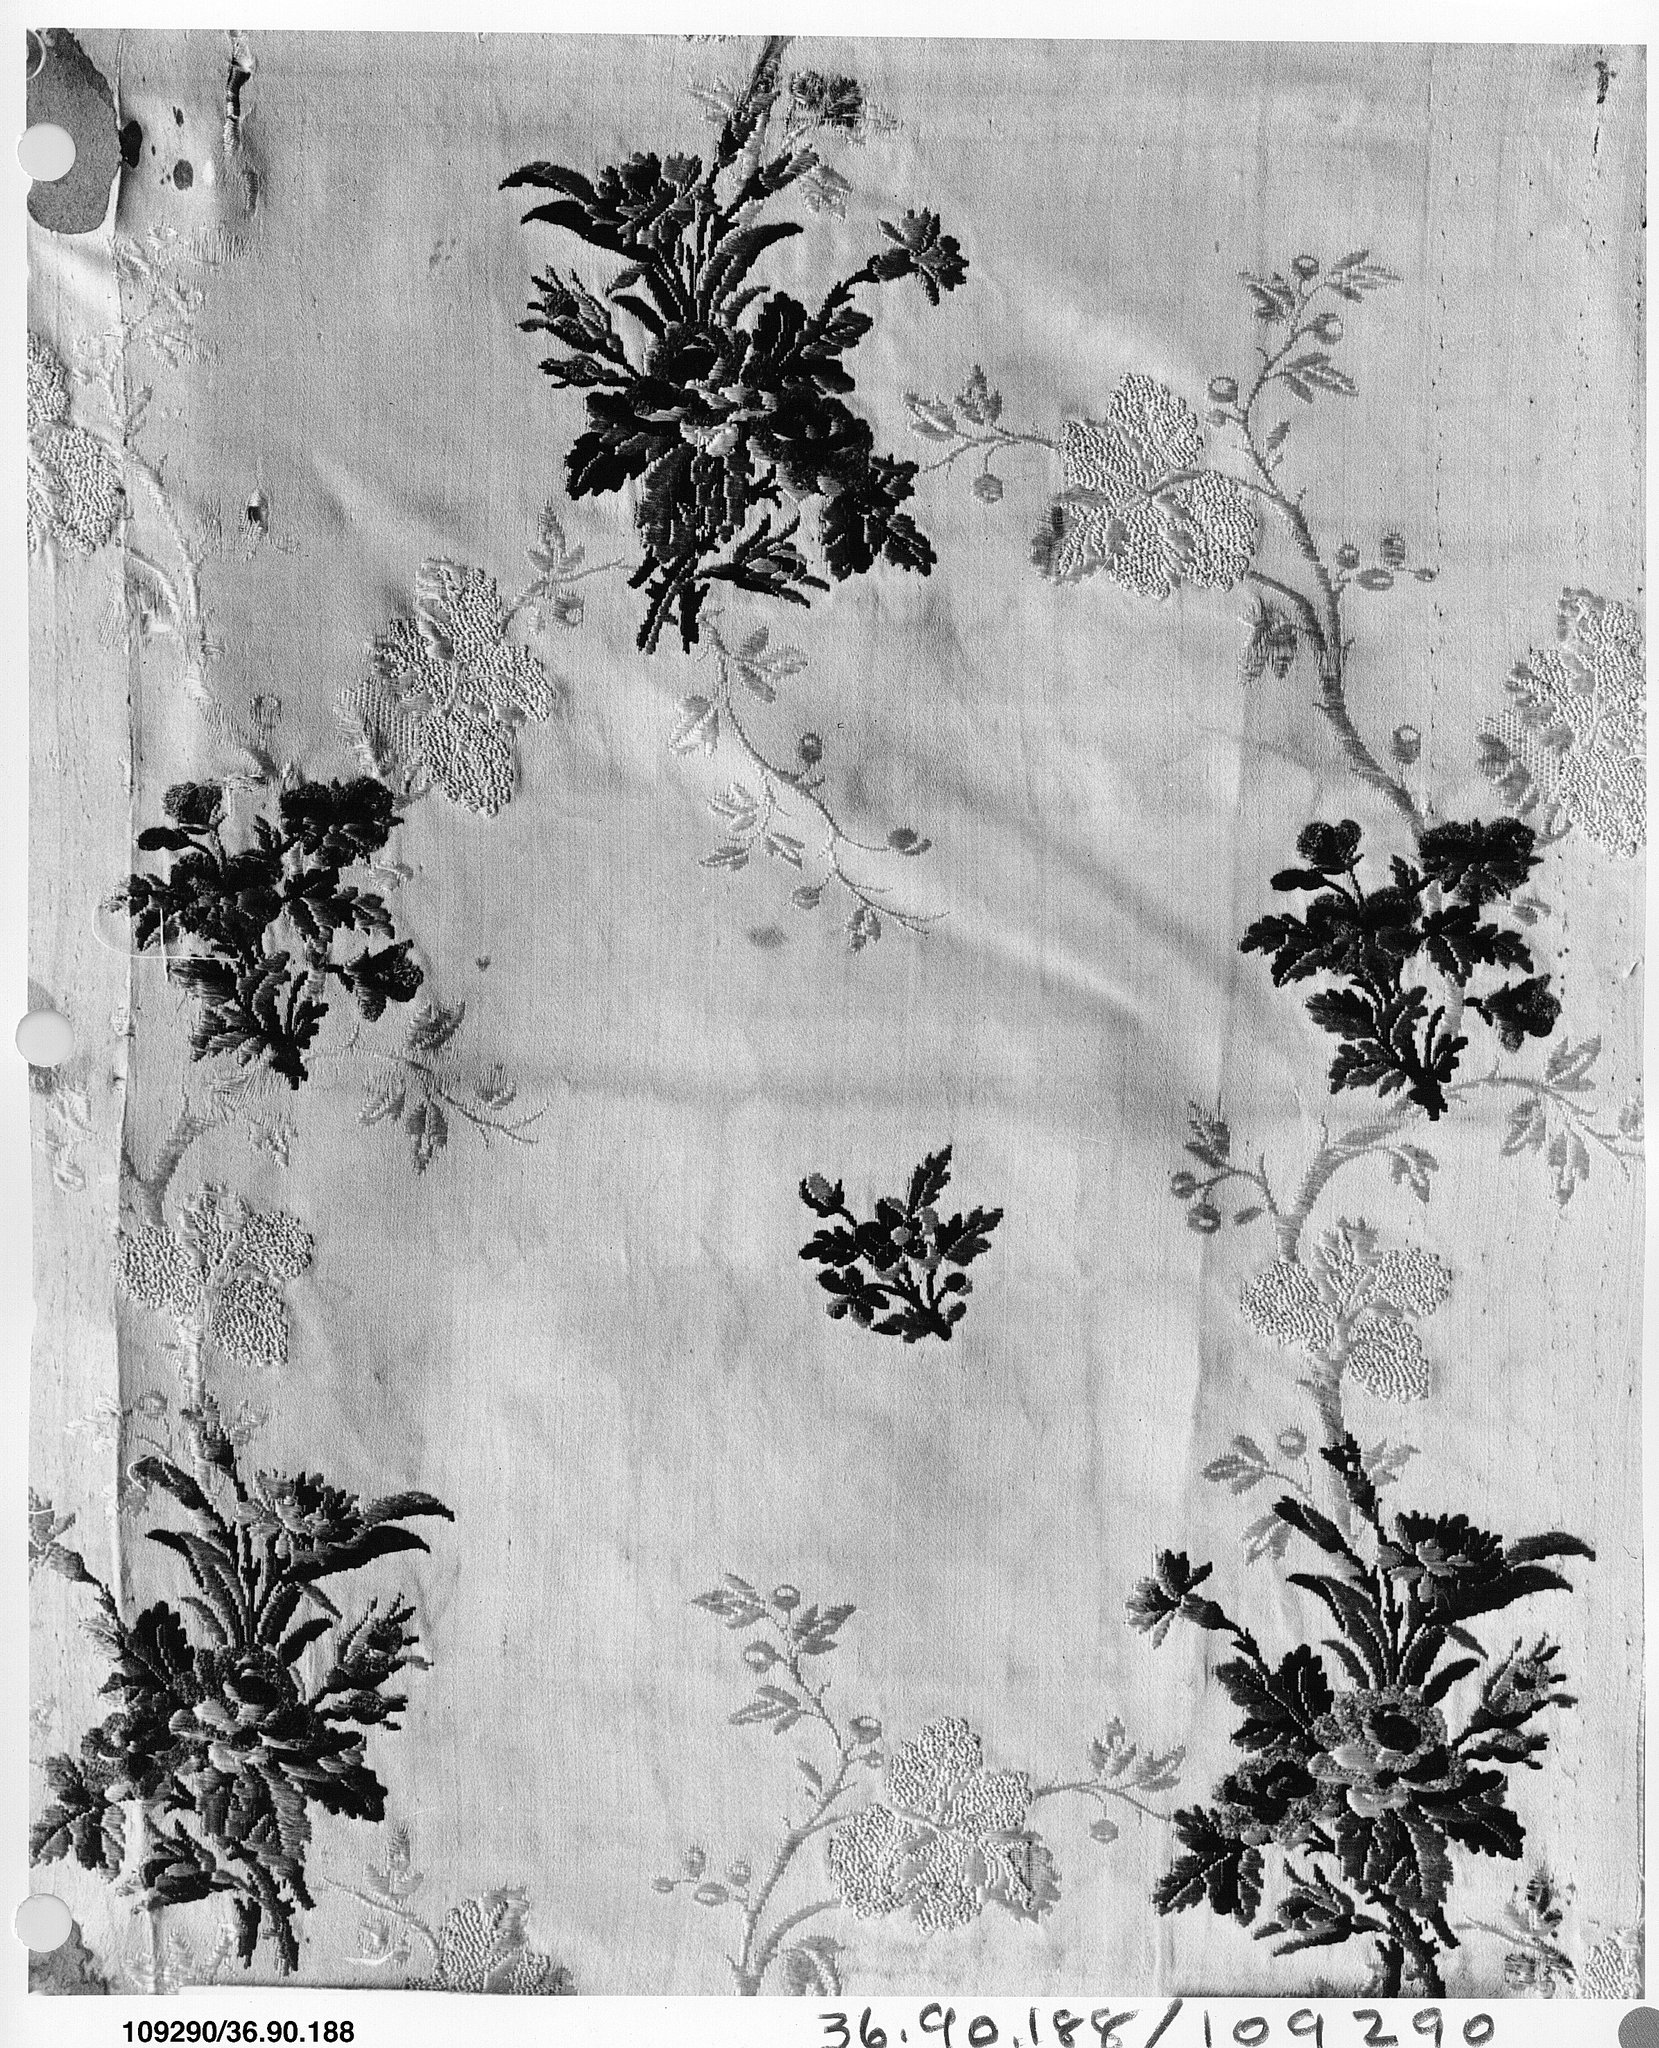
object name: piece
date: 1701-1800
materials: silk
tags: flowers